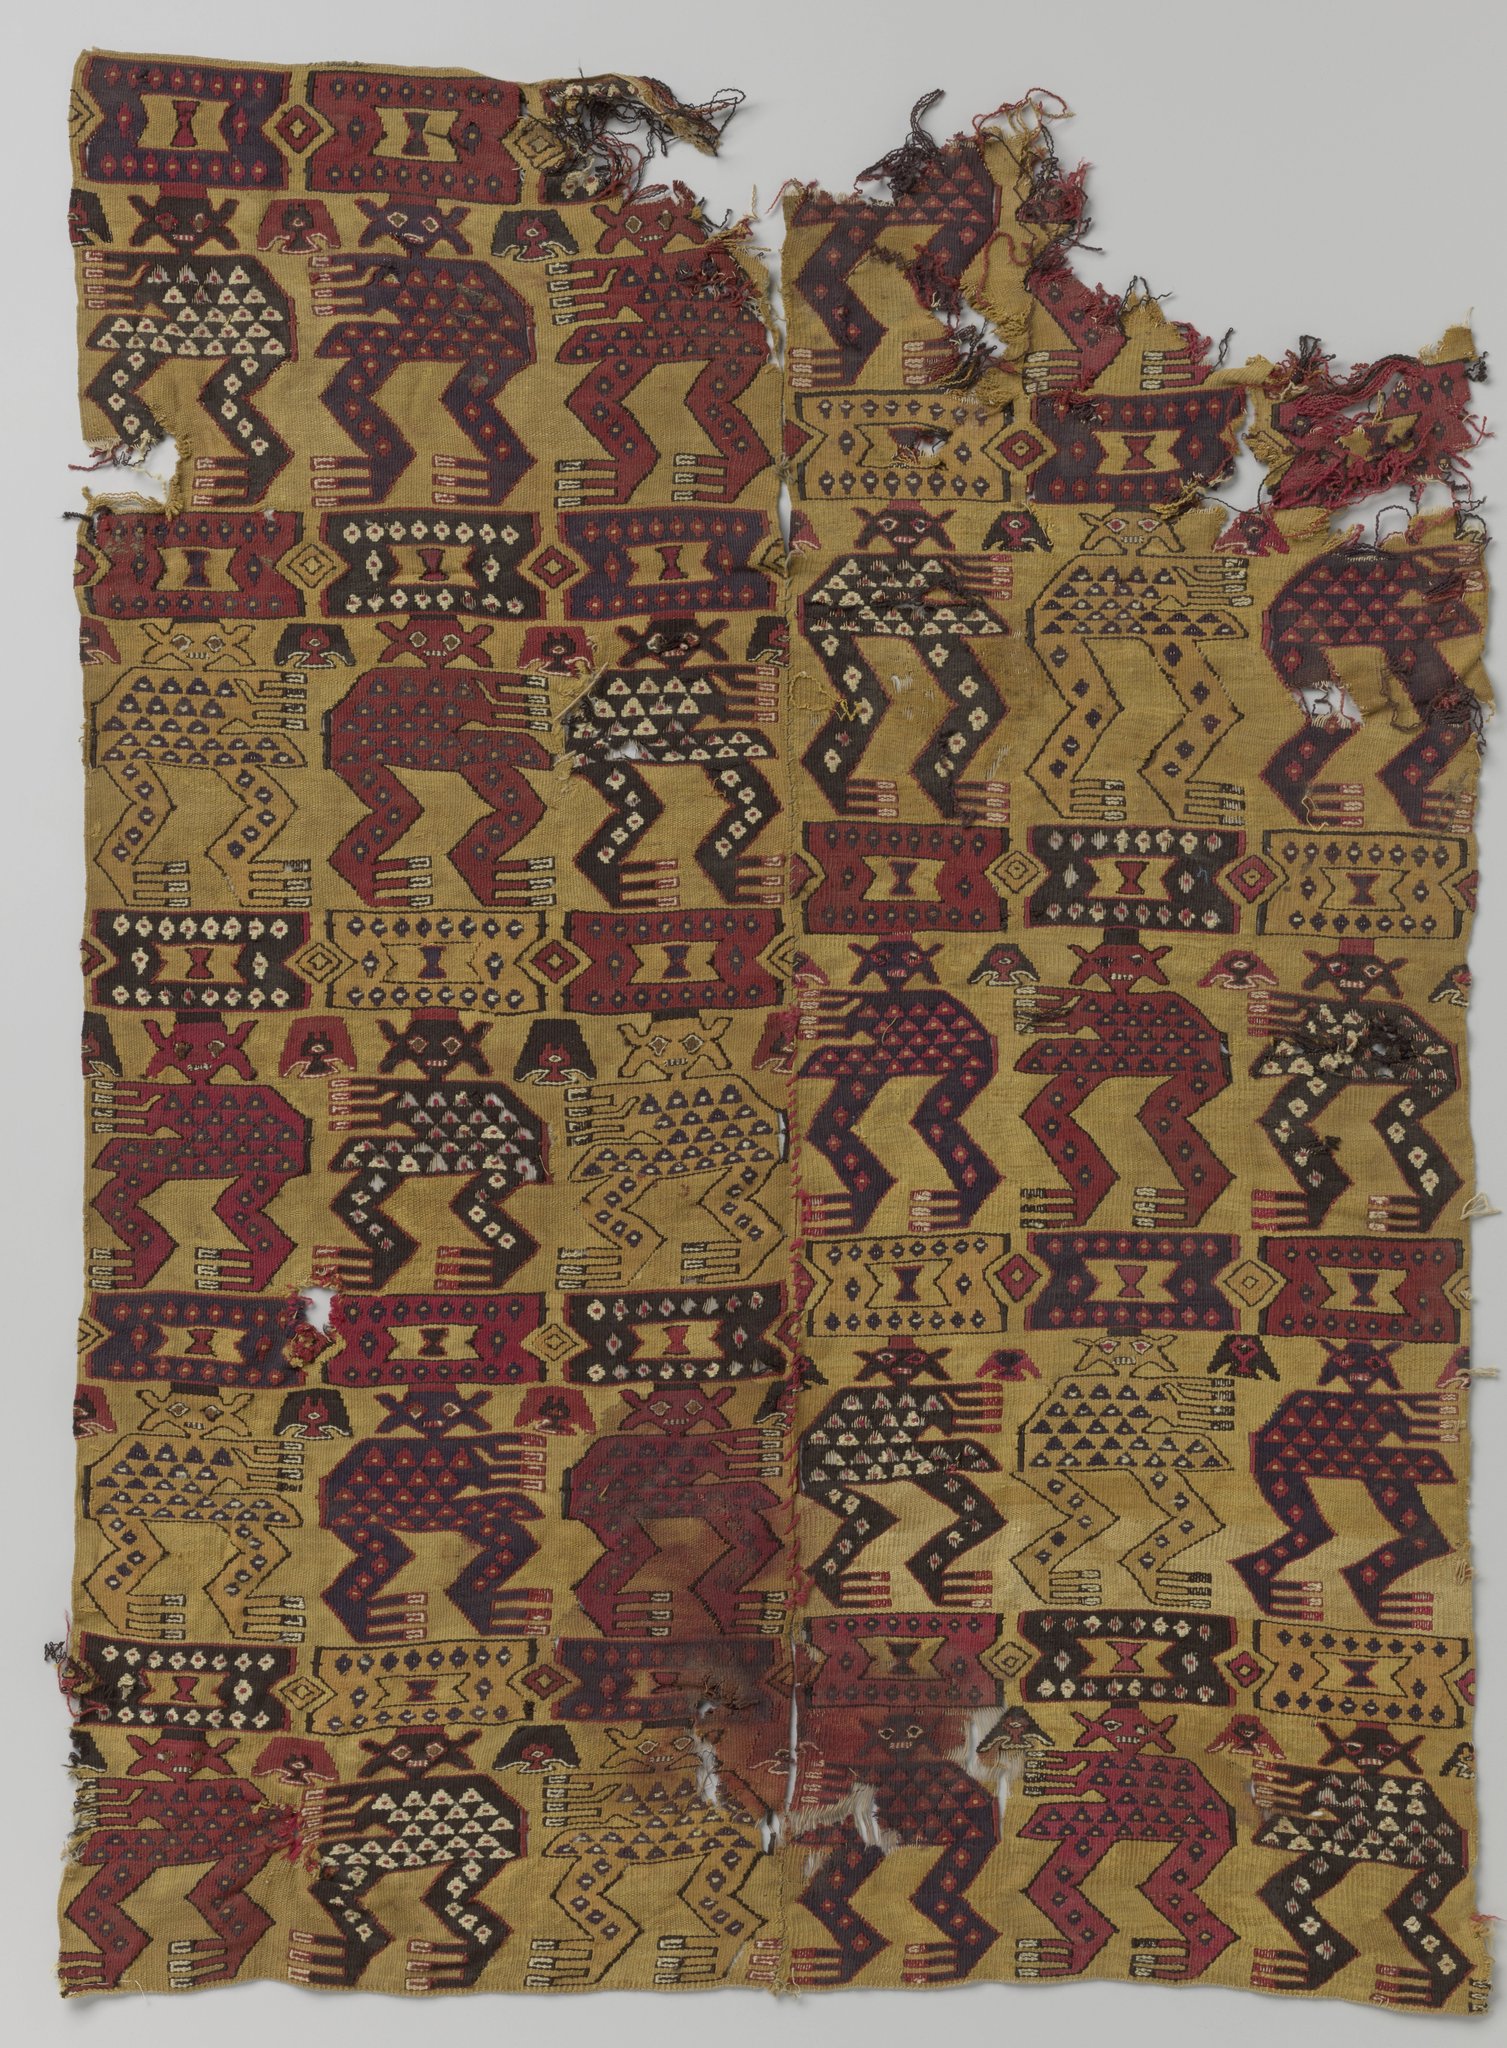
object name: fragment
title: Weefselfragment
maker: Anonymous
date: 1500-1999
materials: cotton, wool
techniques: tapestry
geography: south peru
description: Fragment van twee aan elkaar genaaide stukken met decoratie van afwisselend menselijke en geometrische figuren in wit, rood, geel en zwart op gele grond.